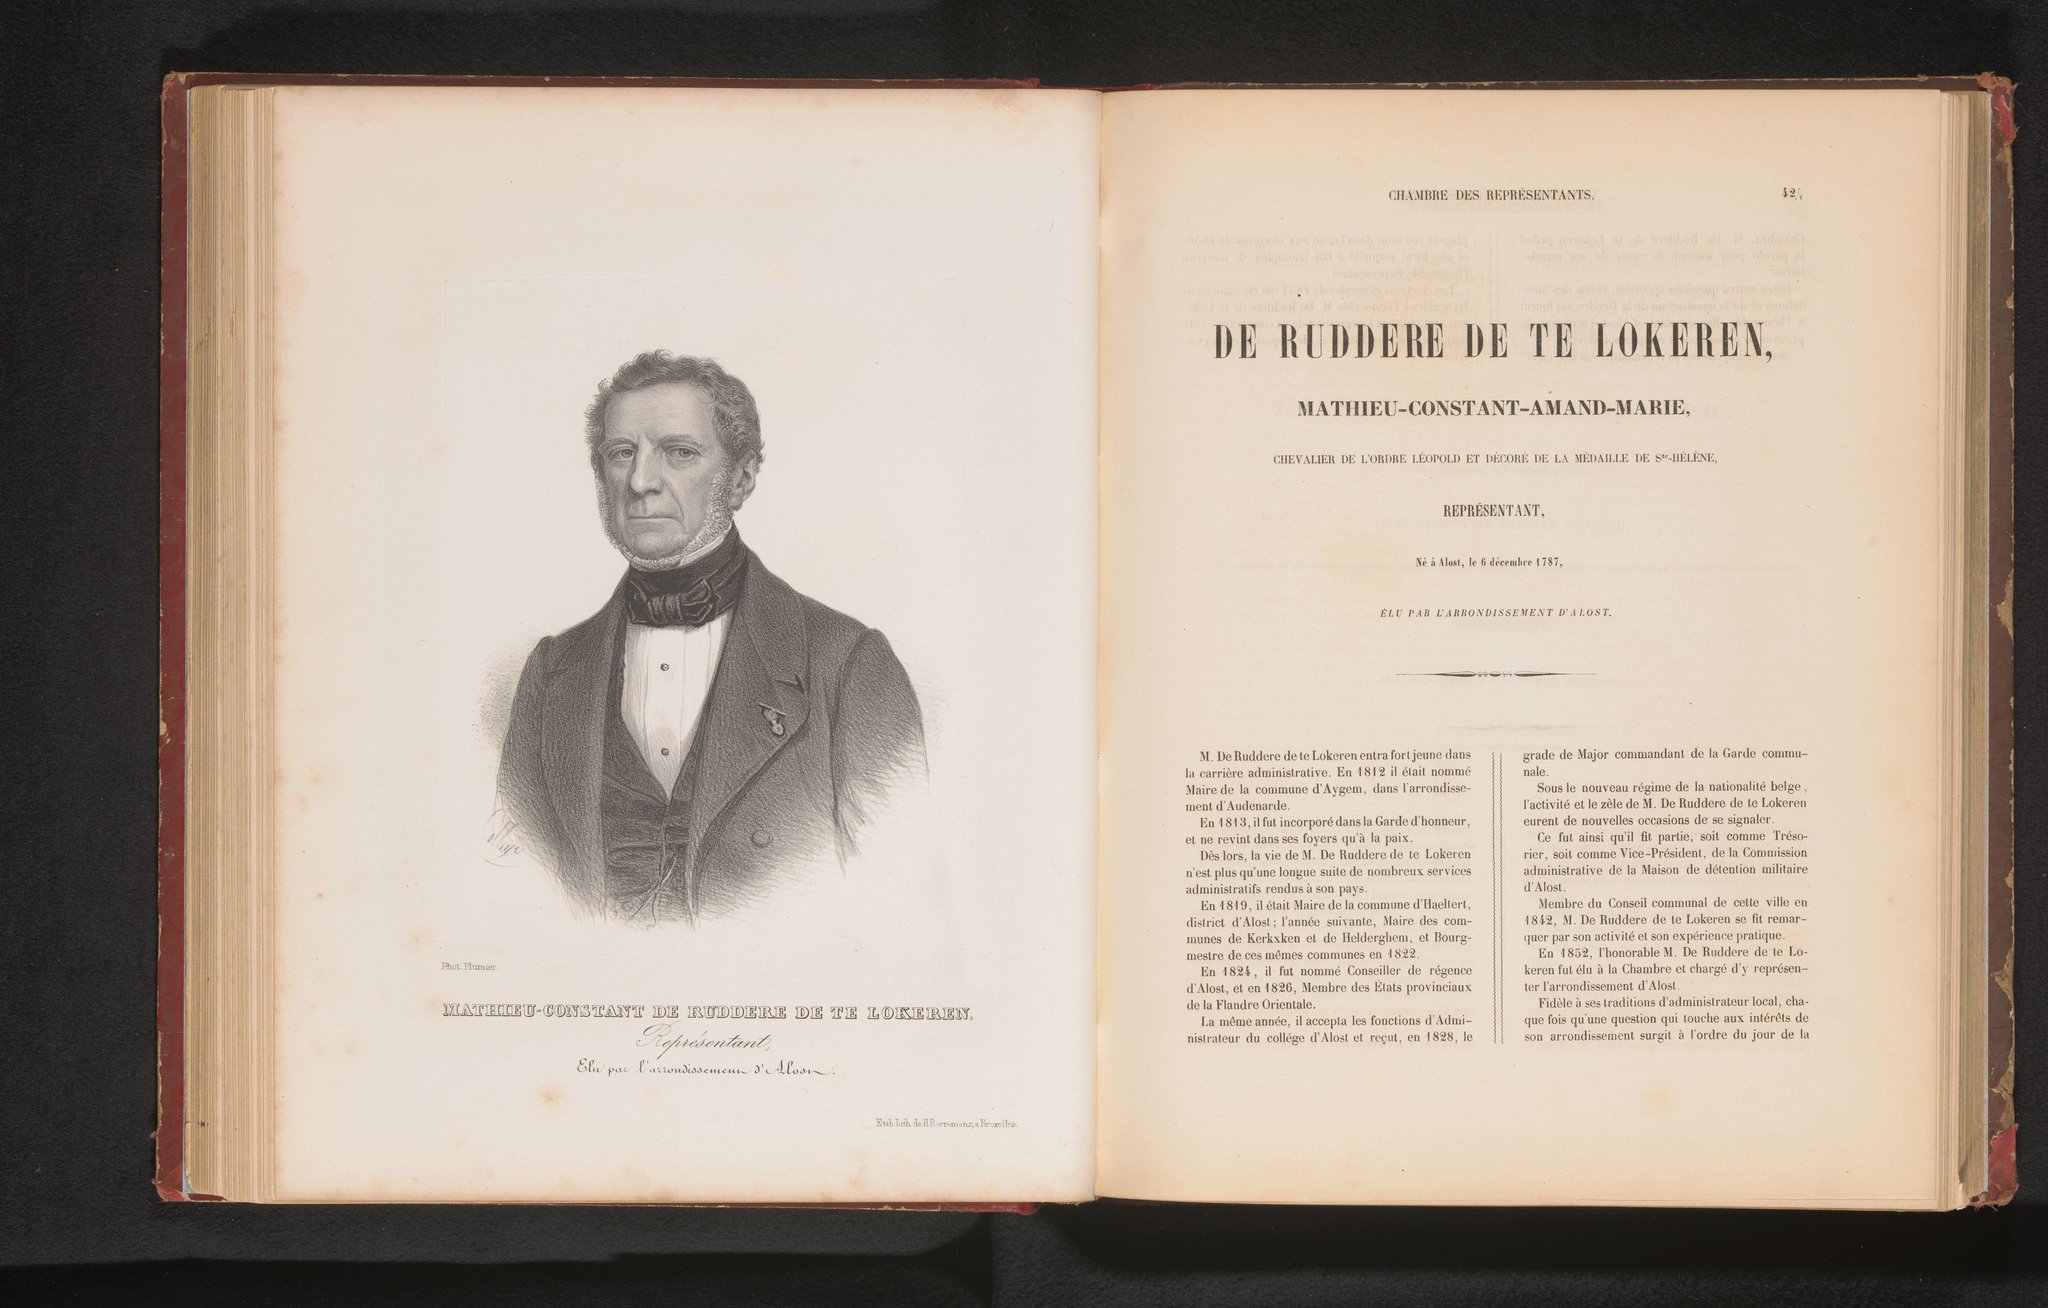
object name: page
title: Reproductie van een foto van een portret van Mathieu de Ruddere de te Lokeren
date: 1853-1858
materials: paper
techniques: lithograph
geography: brussels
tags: historical persons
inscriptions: inscription: ‘Représentant,/ Elu par l'arrondissement d'Alos[t].’